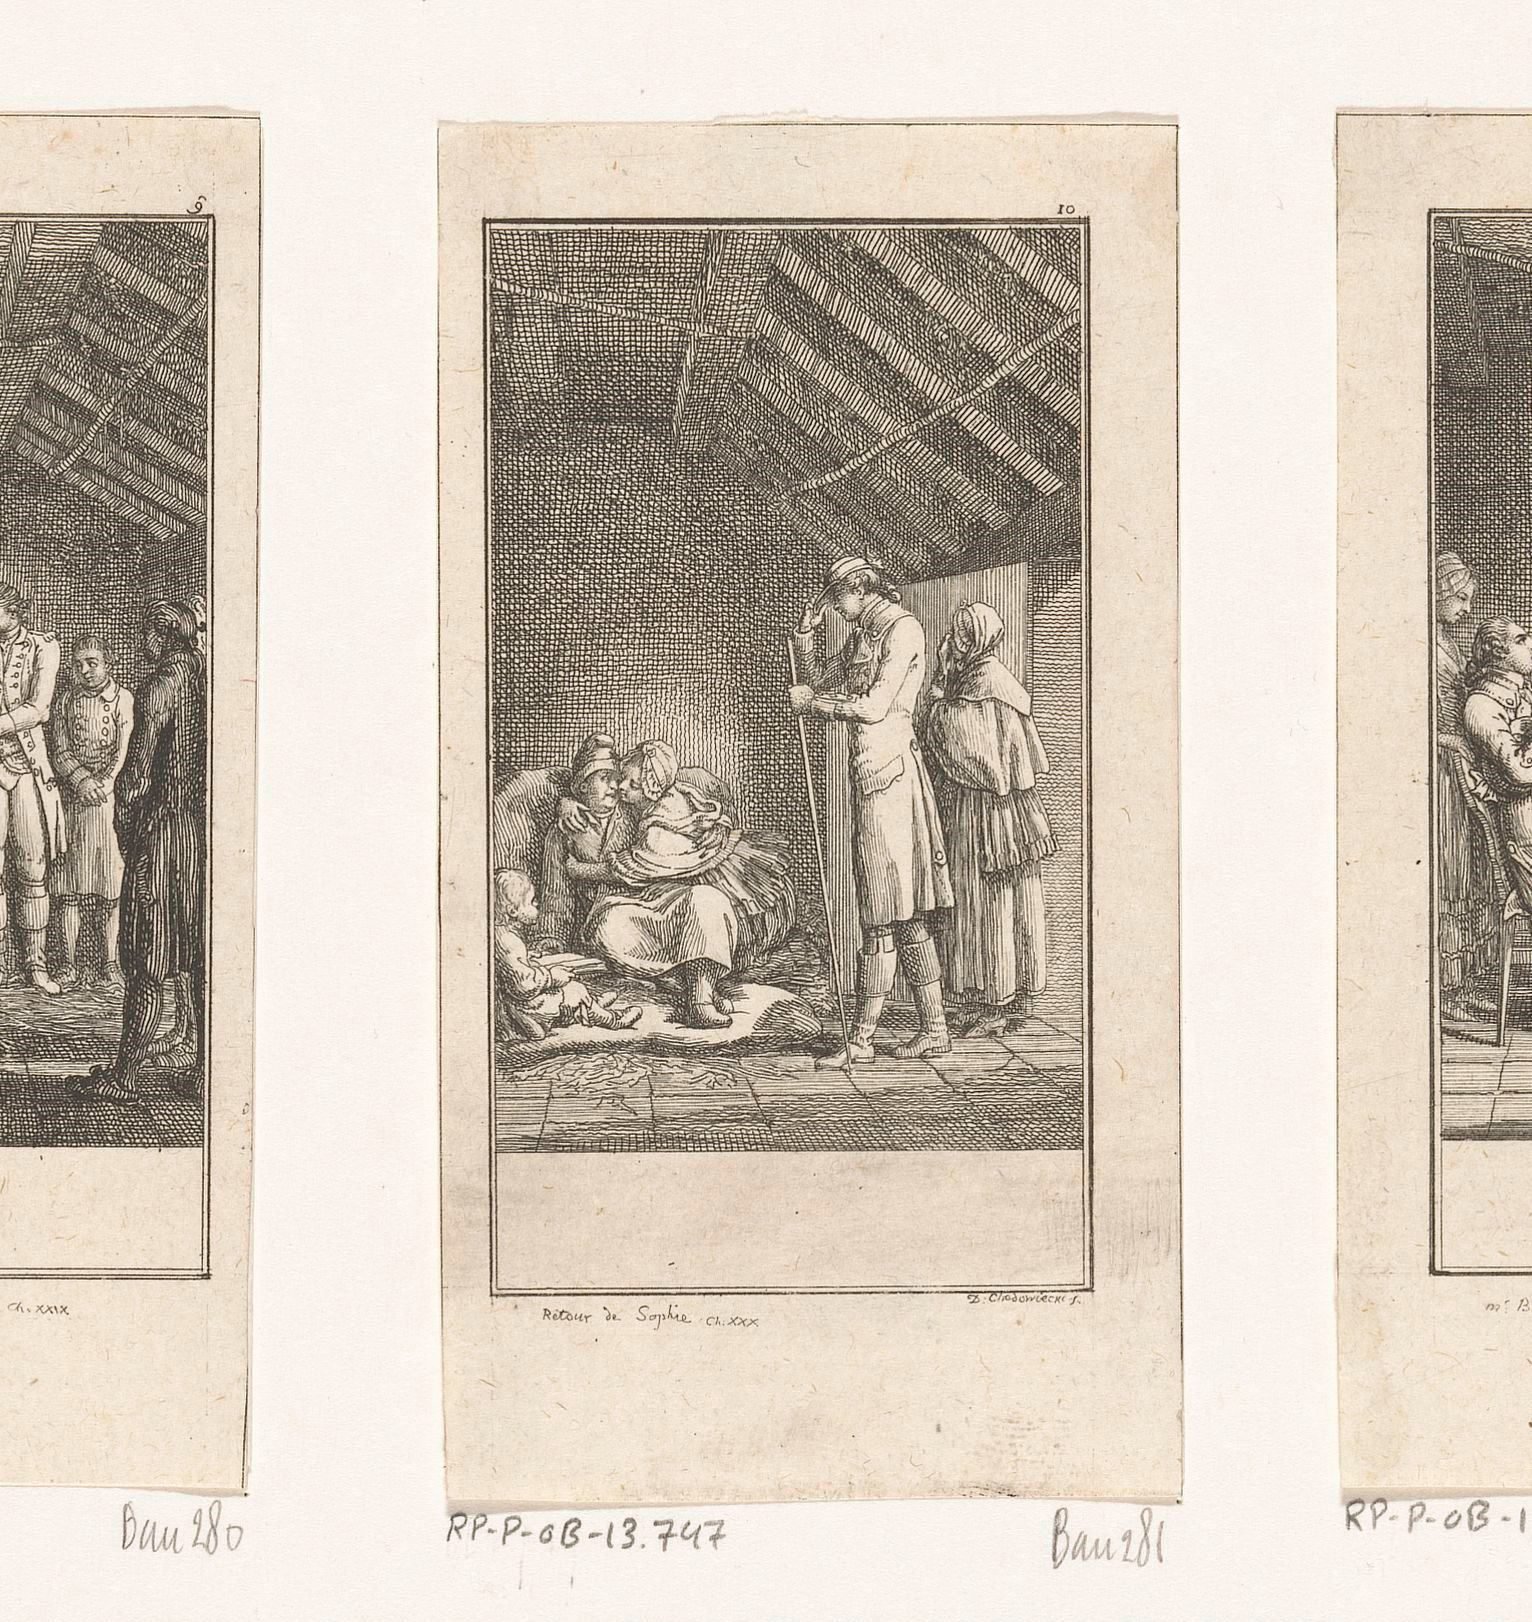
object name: print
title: Retour de Sophie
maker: daniel nikolaus chodowiecki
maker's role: draughtsman, print maker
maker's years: 1726-1801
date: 1776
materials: paper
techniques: etching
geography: berlin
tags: london, oliver goldsmith, (goldsmith, the vicar of wakefield) specific works of literature (with author, title)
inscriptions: collector's mark: Lugt 2228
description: Tiende scène uit een serie van twaalf scènes die 'The Vicar of Wakefield' door Oliver Goldsmith illustreren. De scènes werden op een plaat geëtst. Een latere staat van deze serie is gebruikt in: 'Almanac Généalogique pour l'an 1777 etc. À Berlin'.